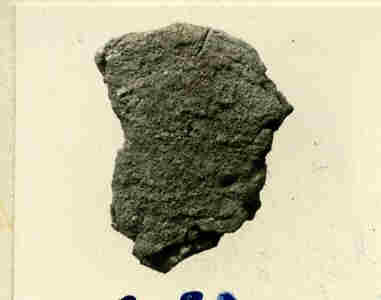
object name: coin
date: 401-1400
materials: copper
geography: iran